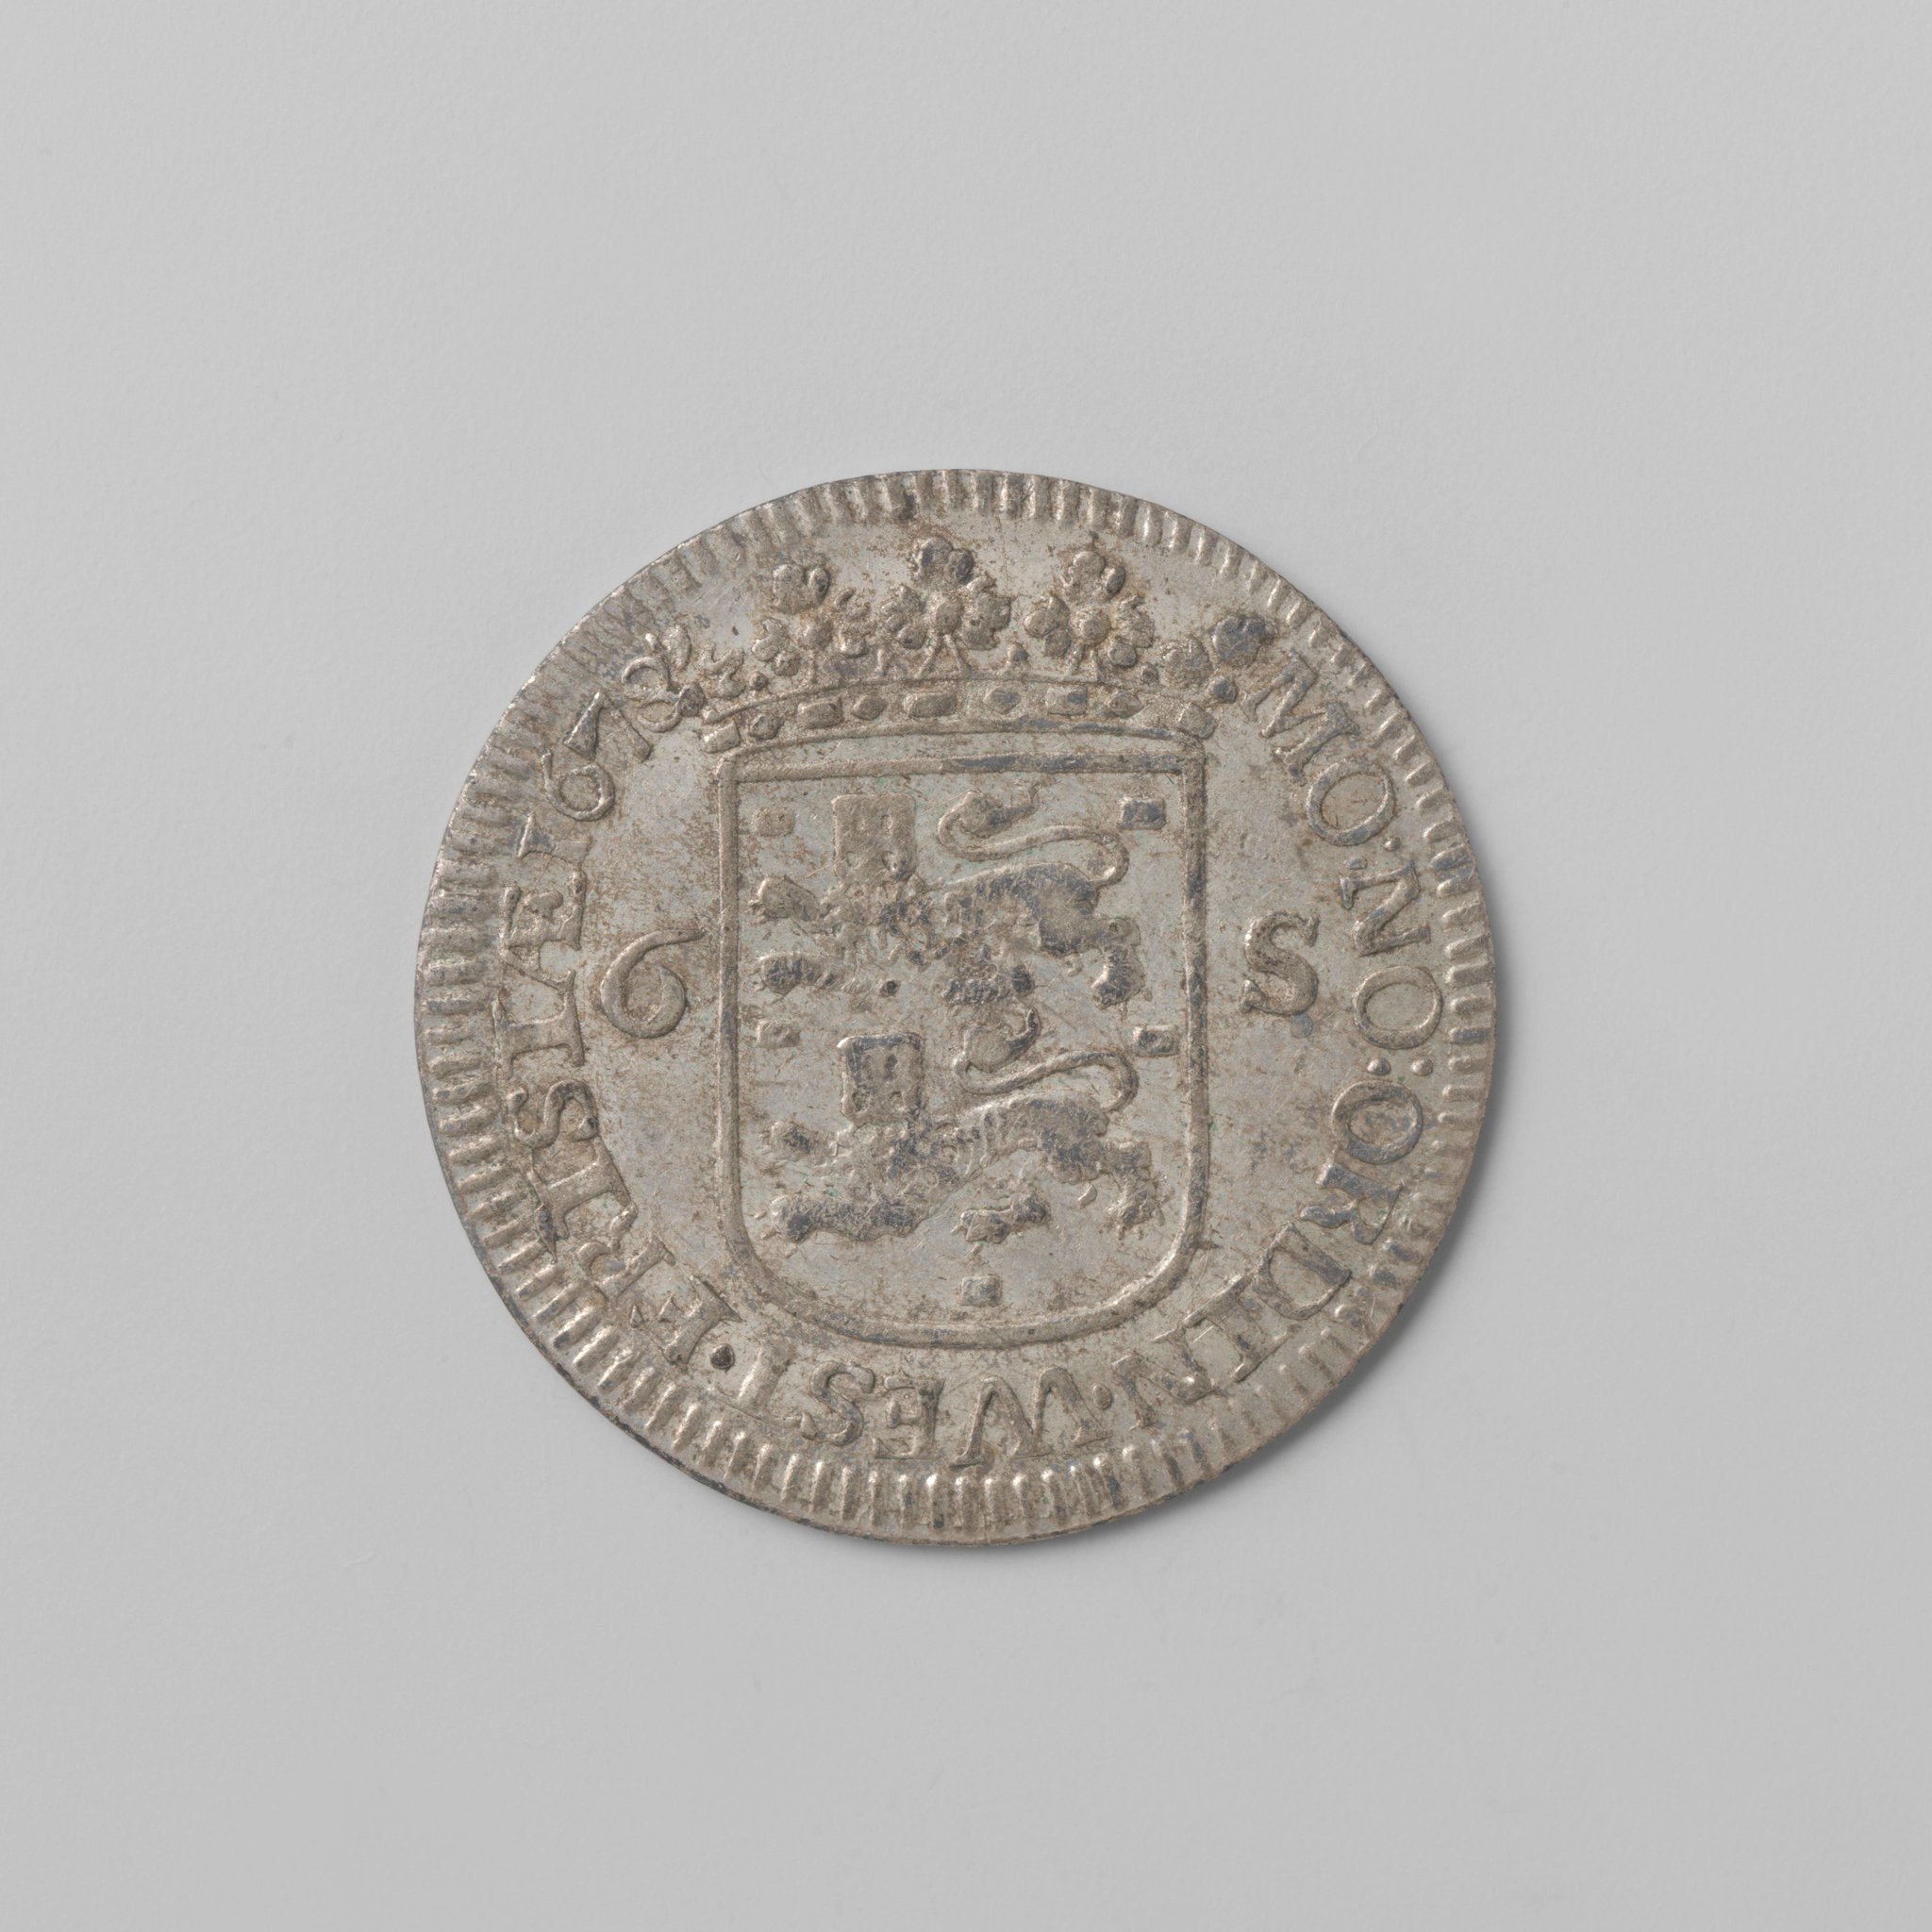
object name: coin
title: Westfriese scheepjesschelling, 1678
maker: dirck bosch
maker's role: mintmaster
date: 1678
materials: silver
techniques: striking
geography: enkhuizen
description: Zilveren munt. Voorzijde: tussen waarde-aanduiding 6 S gekroond wapenschild van West-Friesland. Keerzijde: schip met zeilen naar rechts.